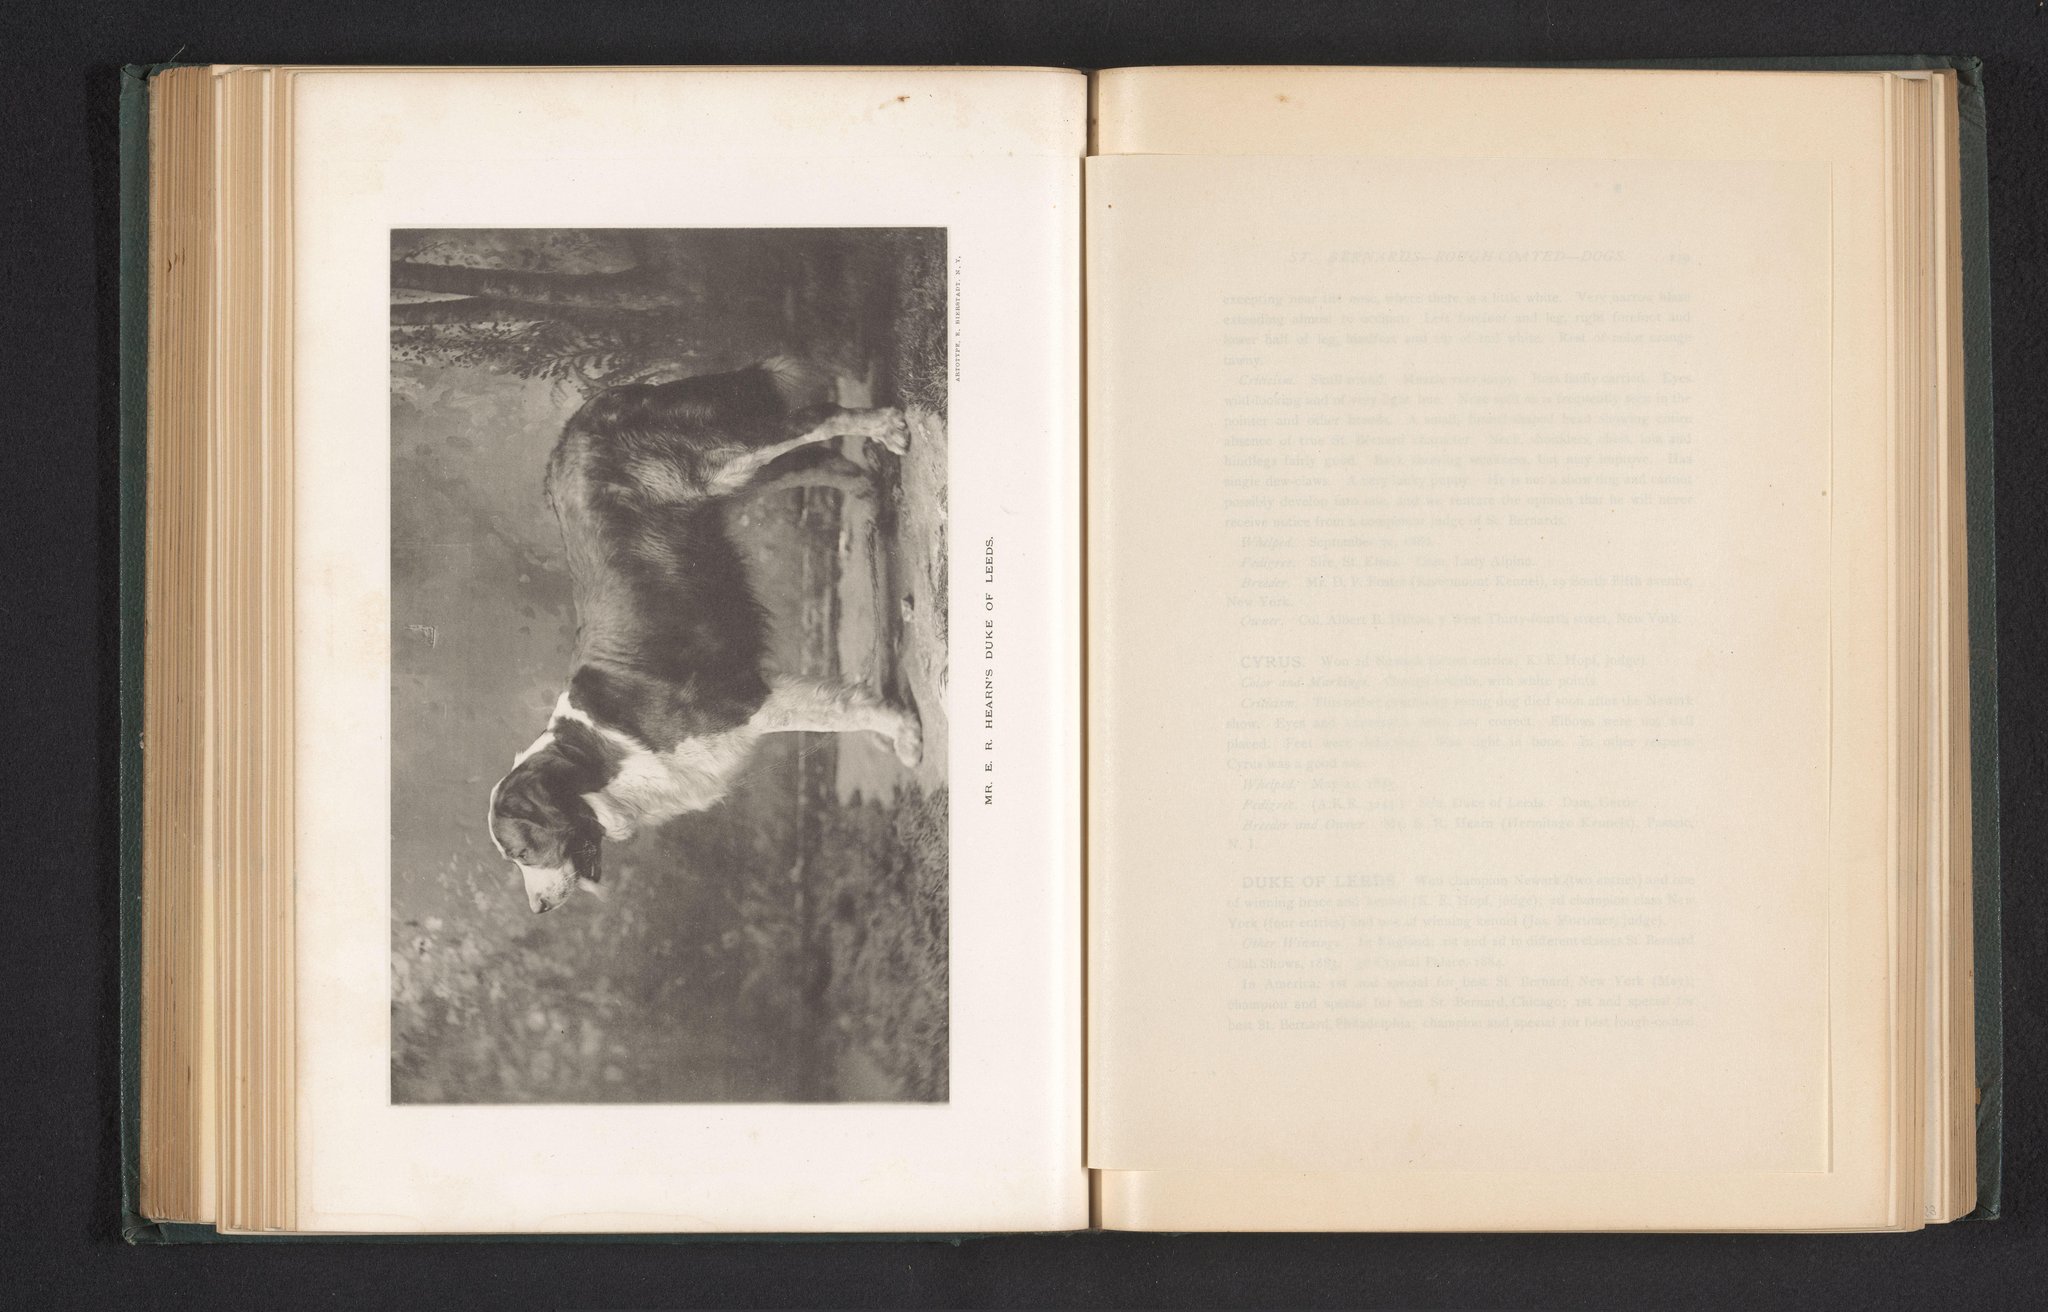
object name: page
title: Sint-bernard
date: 1883-1888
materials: paper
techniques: photograph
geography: new york city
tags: dog (st.bernard)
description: Prent tegenover pagina 279, achter semi-transparante omslag.